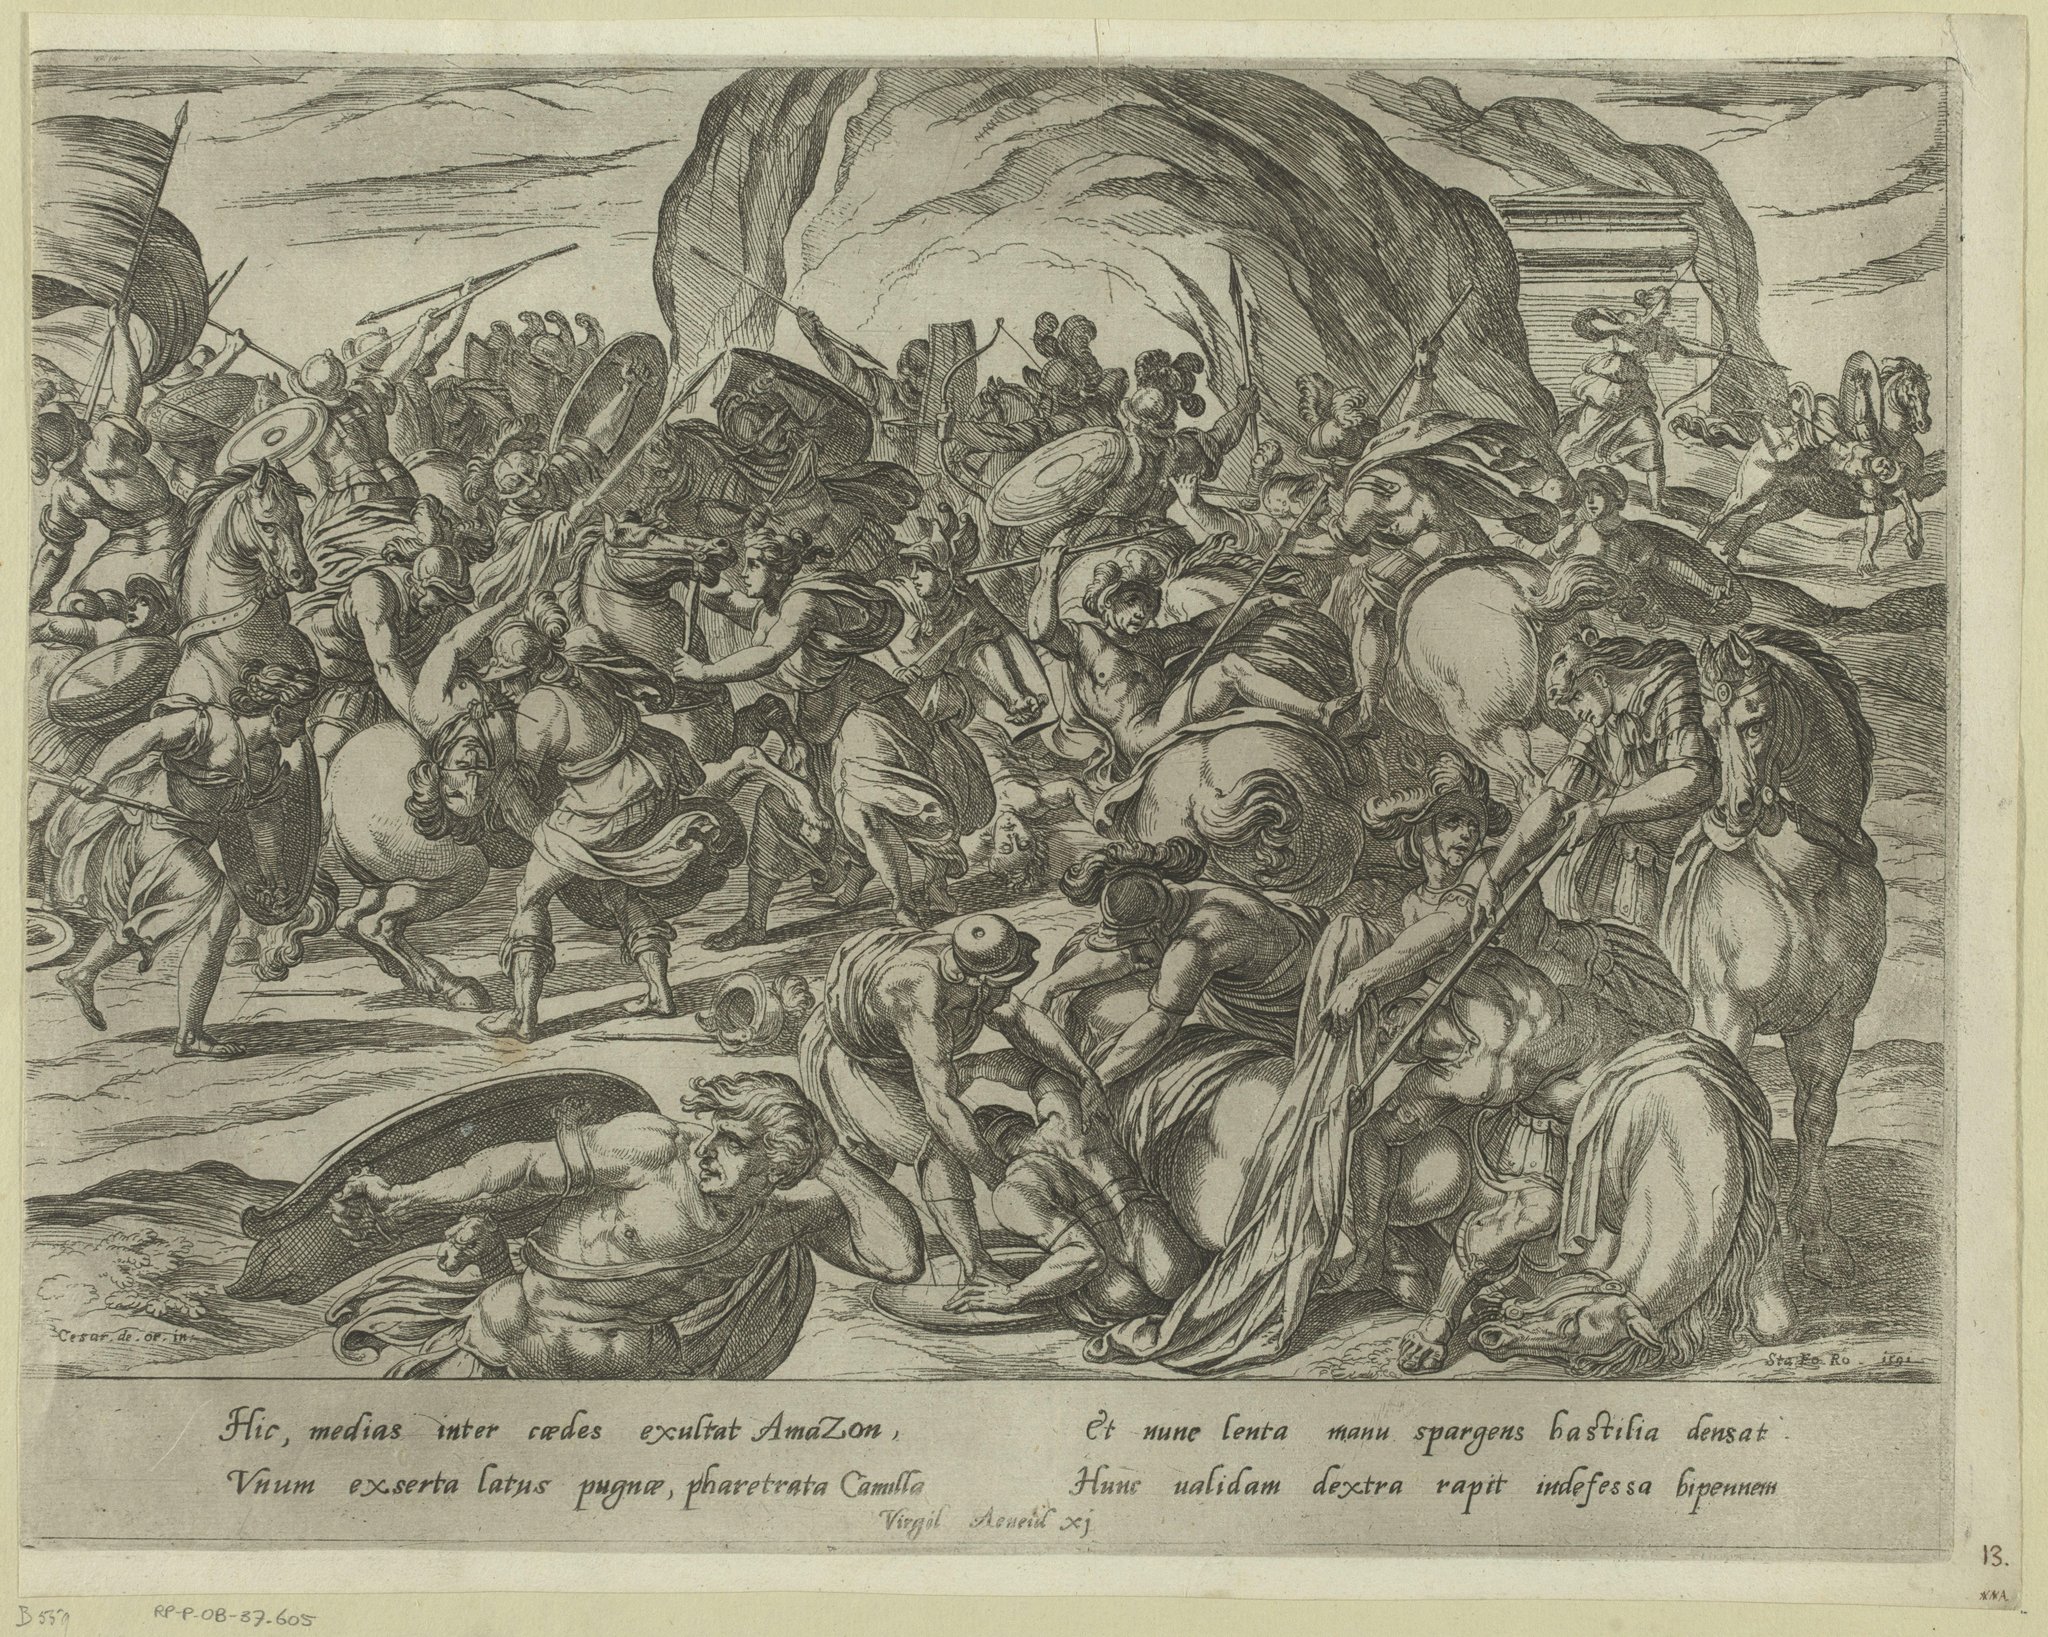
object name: print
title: De dood van Camillus in de strijd tussen Grieken en Romeinen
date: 1591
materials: paper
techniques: etching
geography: rome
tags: (story of) camilla - death, battle, the soldier; the soldier's life, warfare; military affairs (+ land forces)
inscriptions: number: ‘13’, collector's mark: Lugt 240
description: De dood van Camillus in een strijdgewoel van Griekse en Romeinse soldaten te paard. Vers in het Latijn in ondermarge.